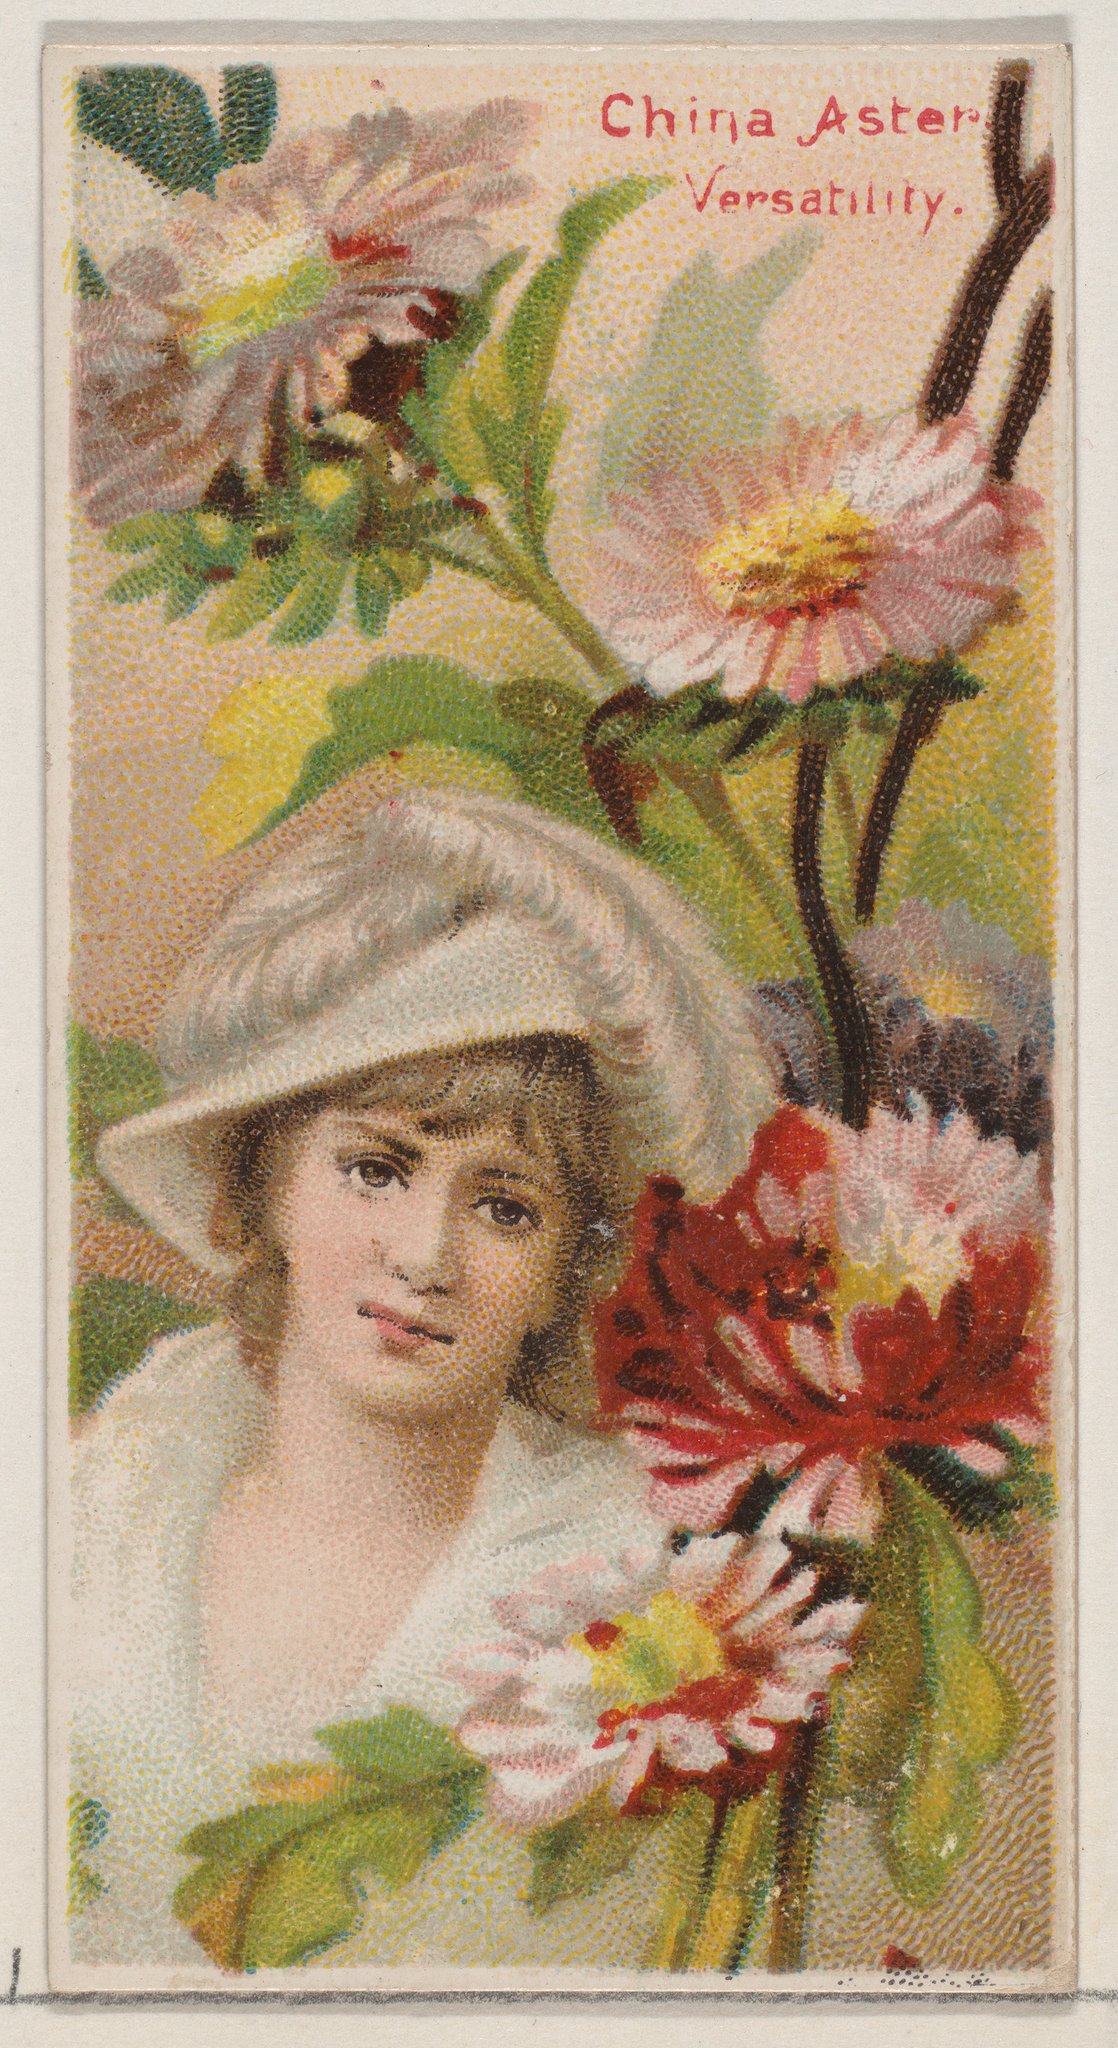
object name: print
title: China Aster: Versatility, from the series Floral Beauties and Language of Flowers (N75) for Duke brand cigarettes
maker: american tobacco company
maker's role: publisher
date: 1892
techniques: color lithograph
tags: women,flowers